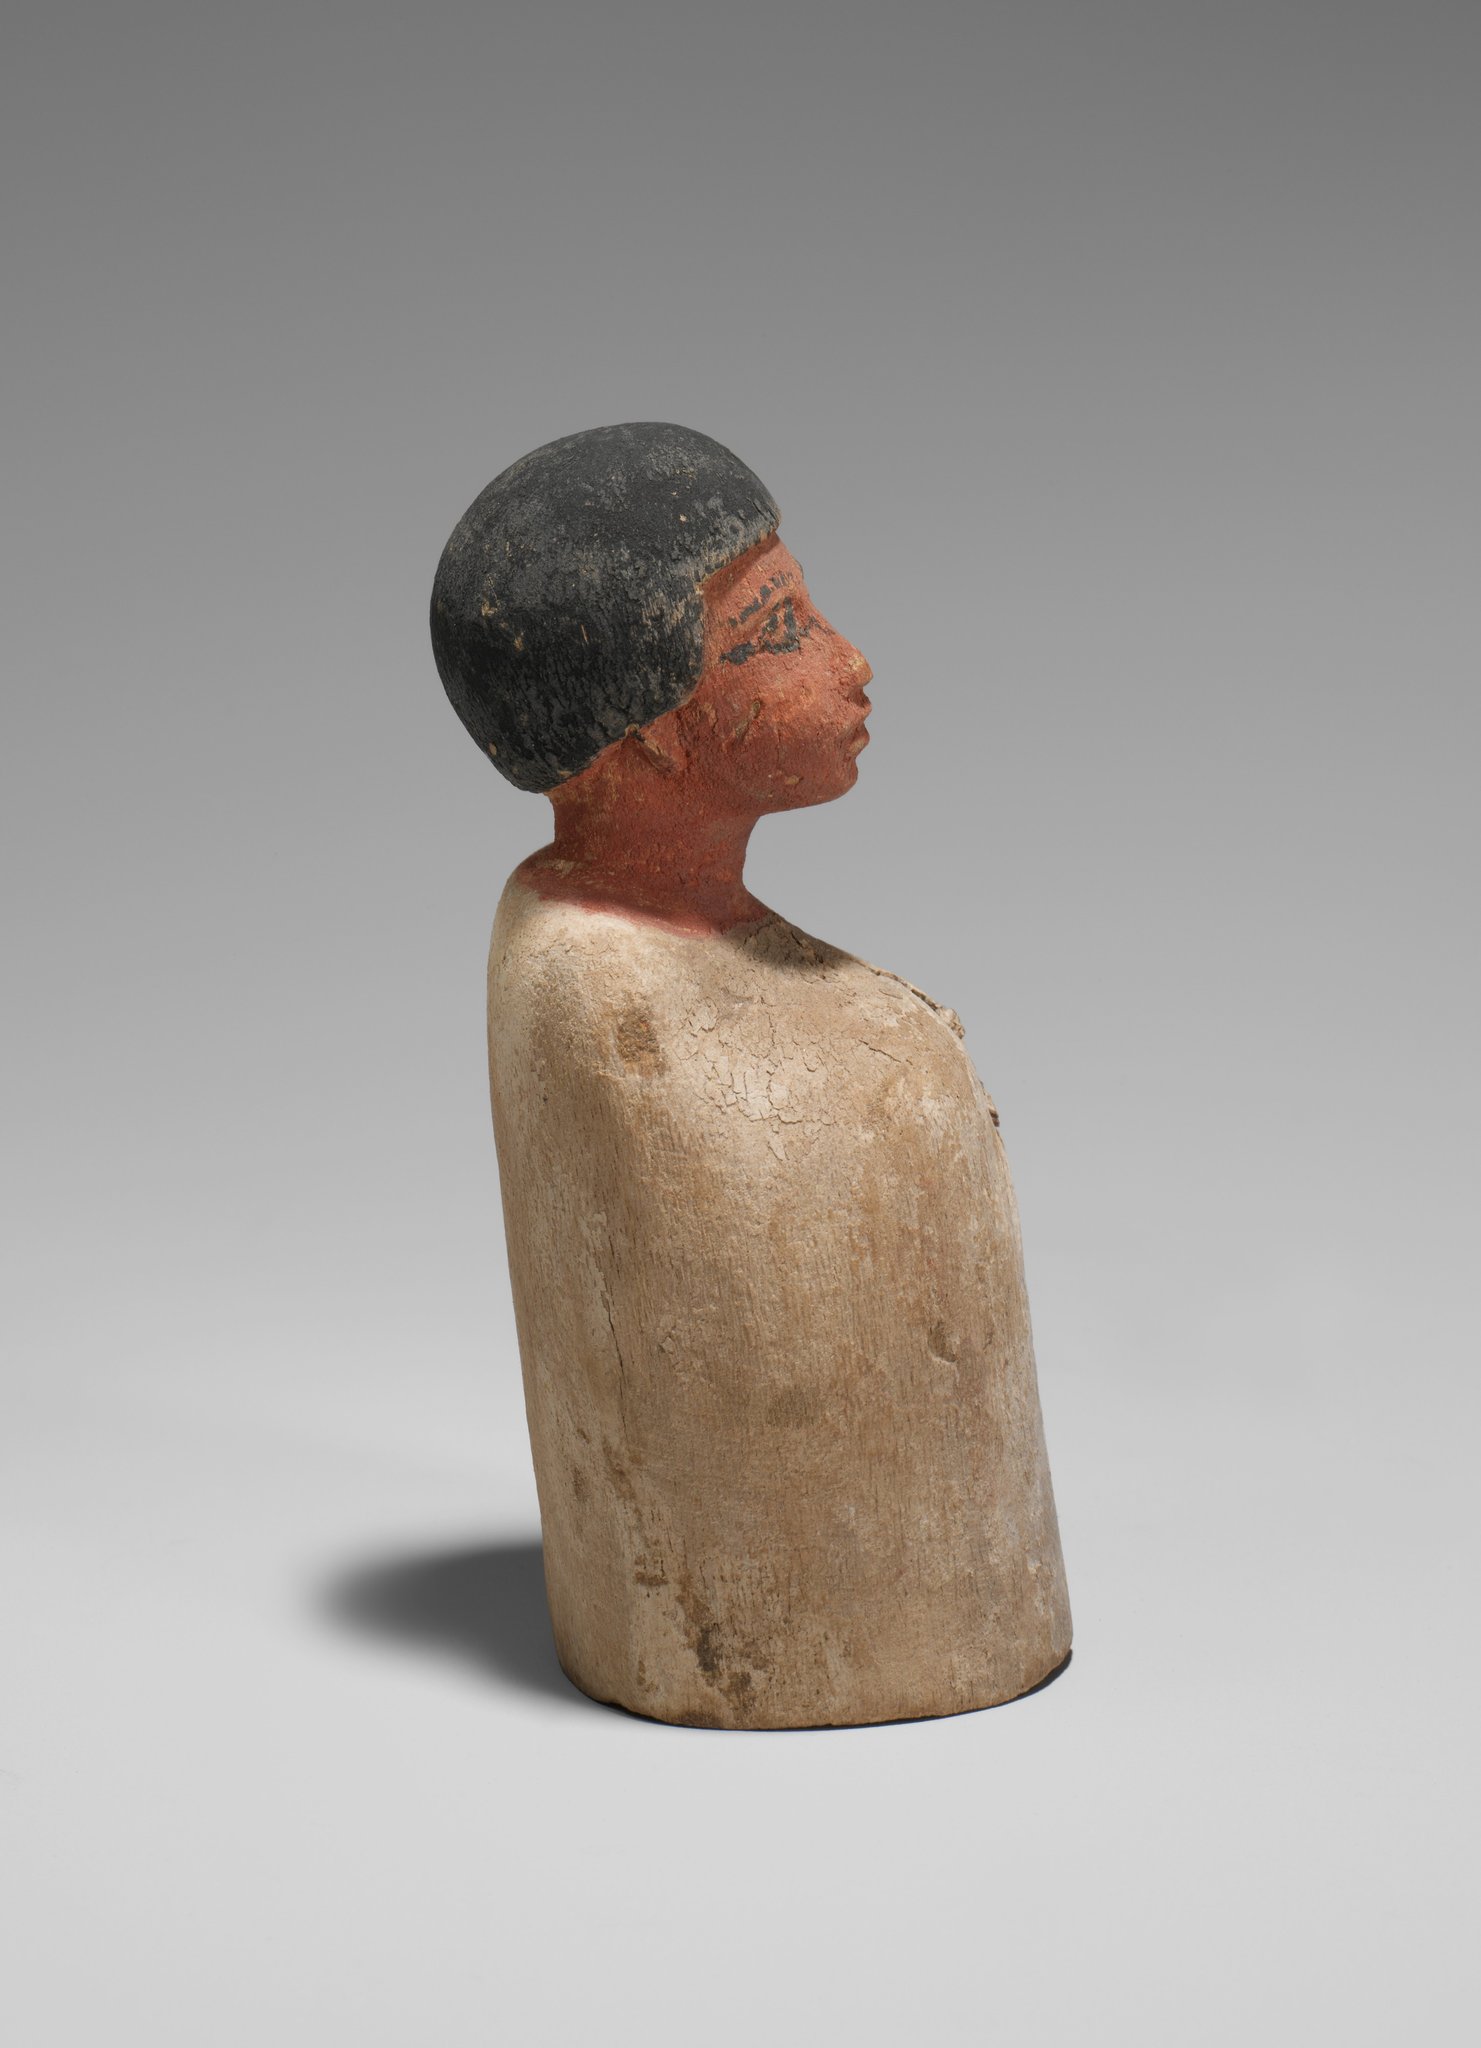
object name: model boatman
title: Figure from a model boat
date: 1981-1640 BCE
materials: paint, wood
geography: egypt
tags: women